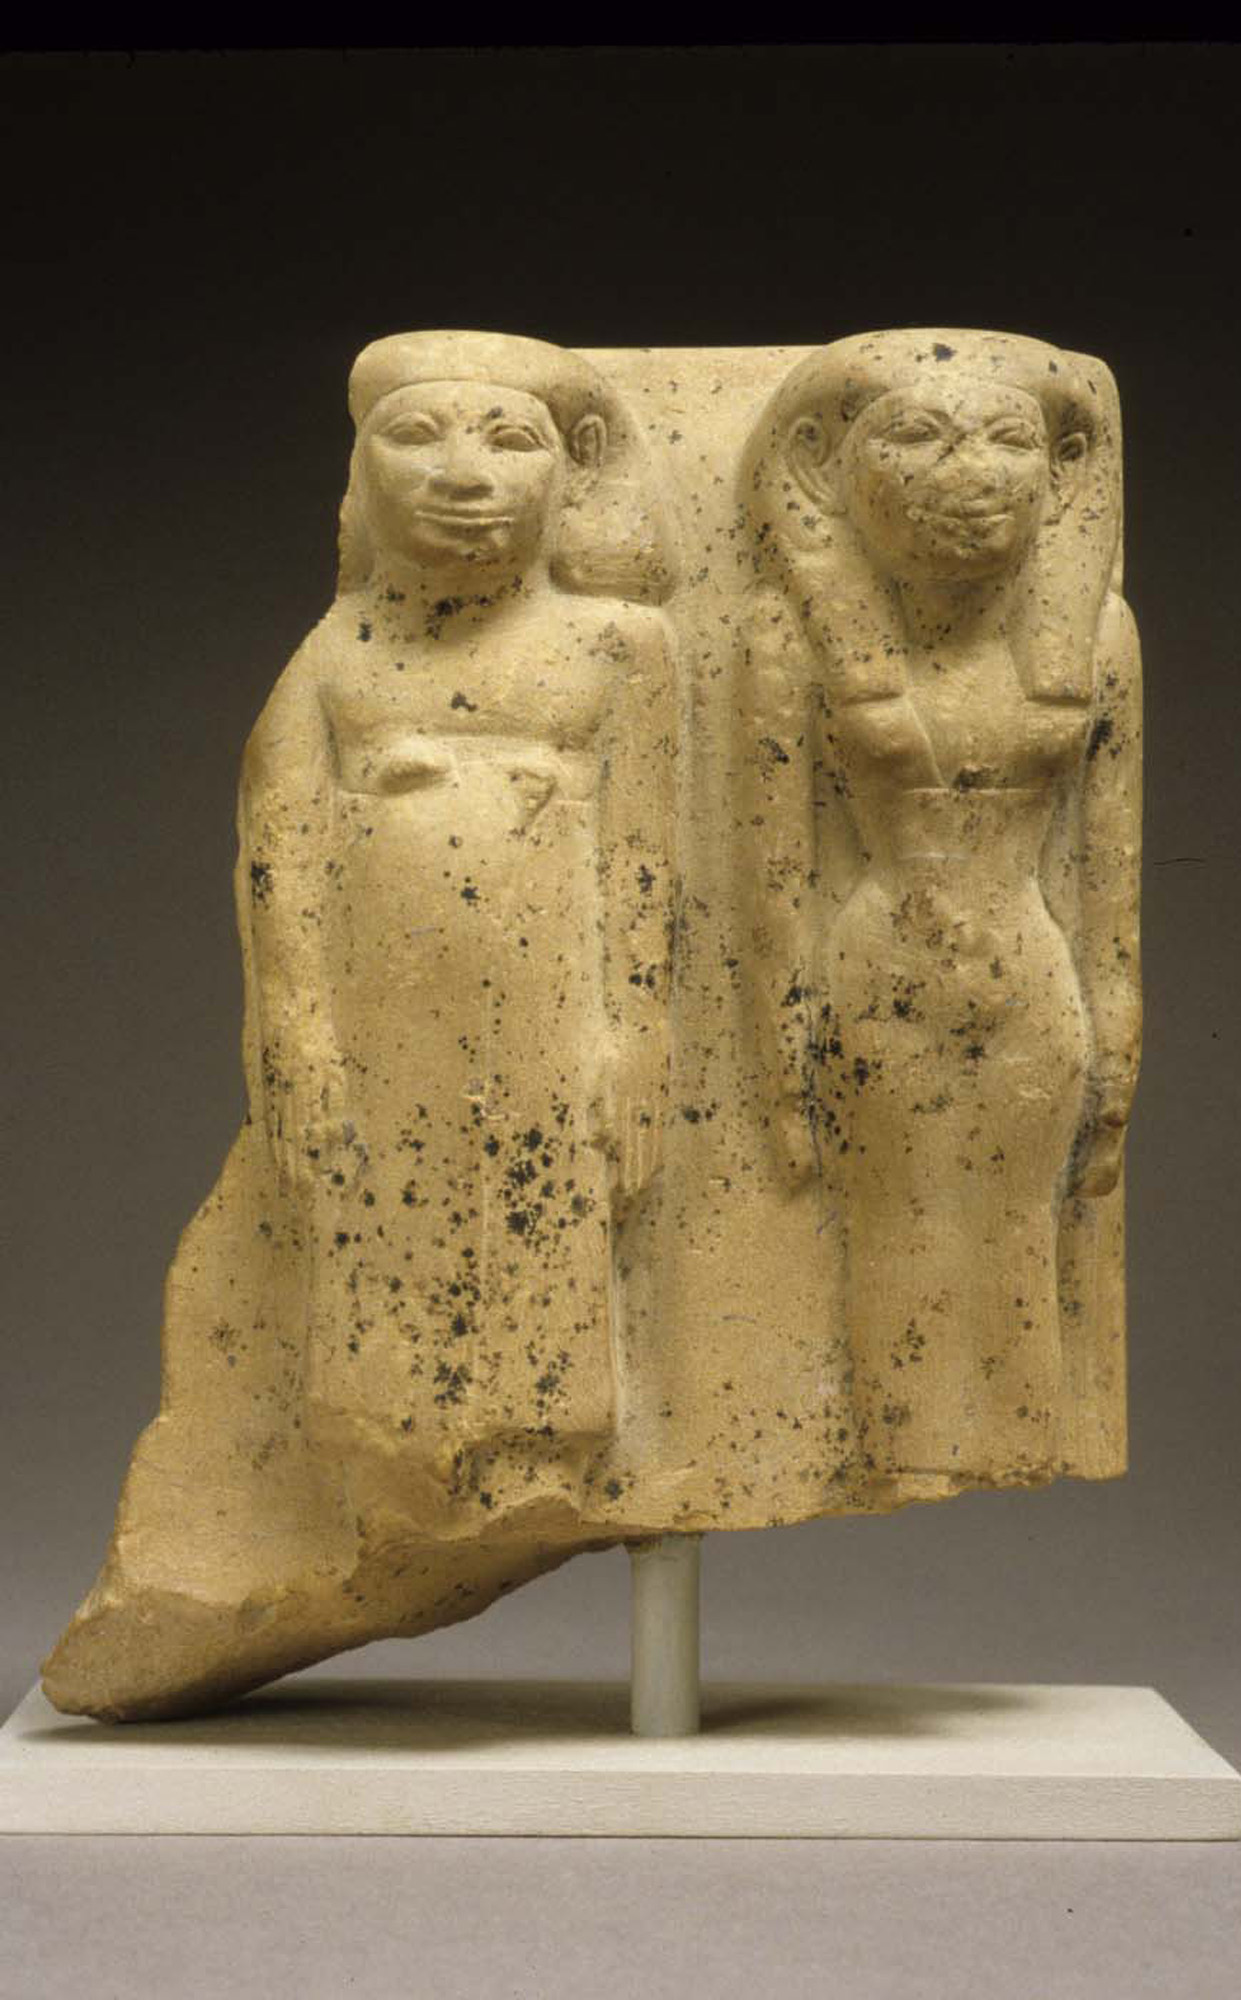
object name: statue group, man and woman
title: Group statue of man and woman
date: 1850-1640 BCE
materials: limestone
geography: egypt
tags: men,women